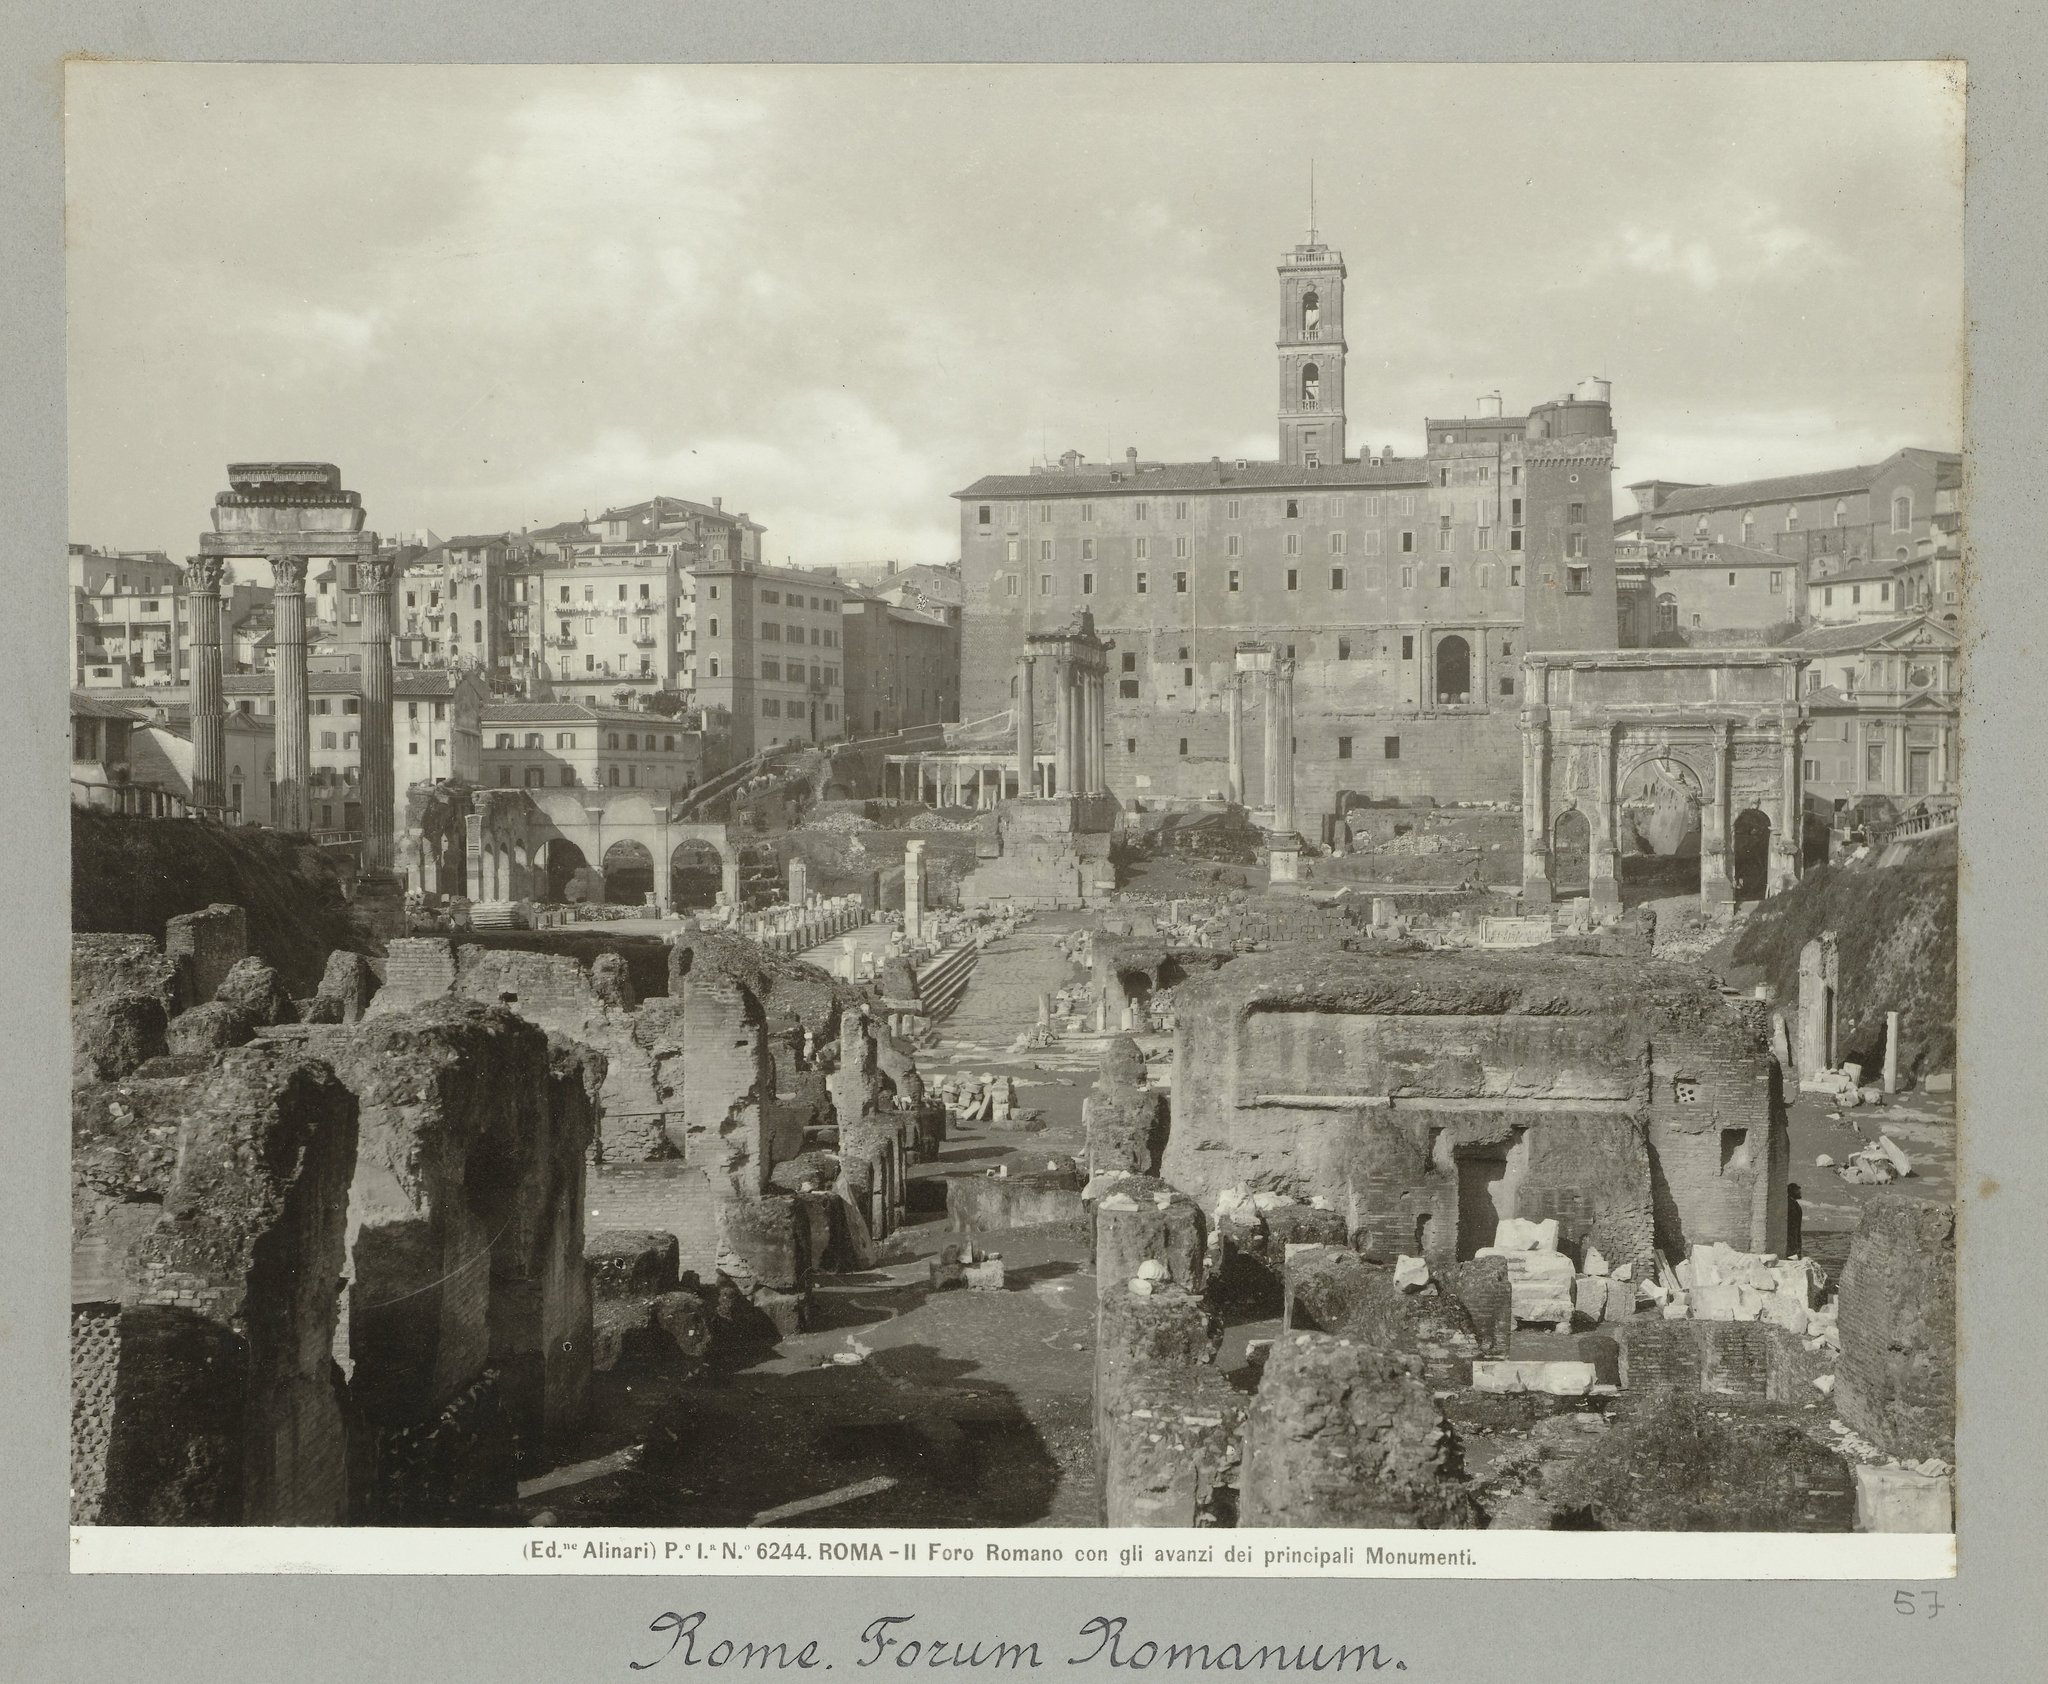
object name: photograph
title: P.I.N. 6244 Roma. Il foro Romano con gli avanzi dei principali monumenti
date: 1893-1903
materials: cardboard, photographic support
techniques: albumen print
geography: netherlands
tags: forum romanum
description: Uitzicht over het Forum Romanum in Rome.